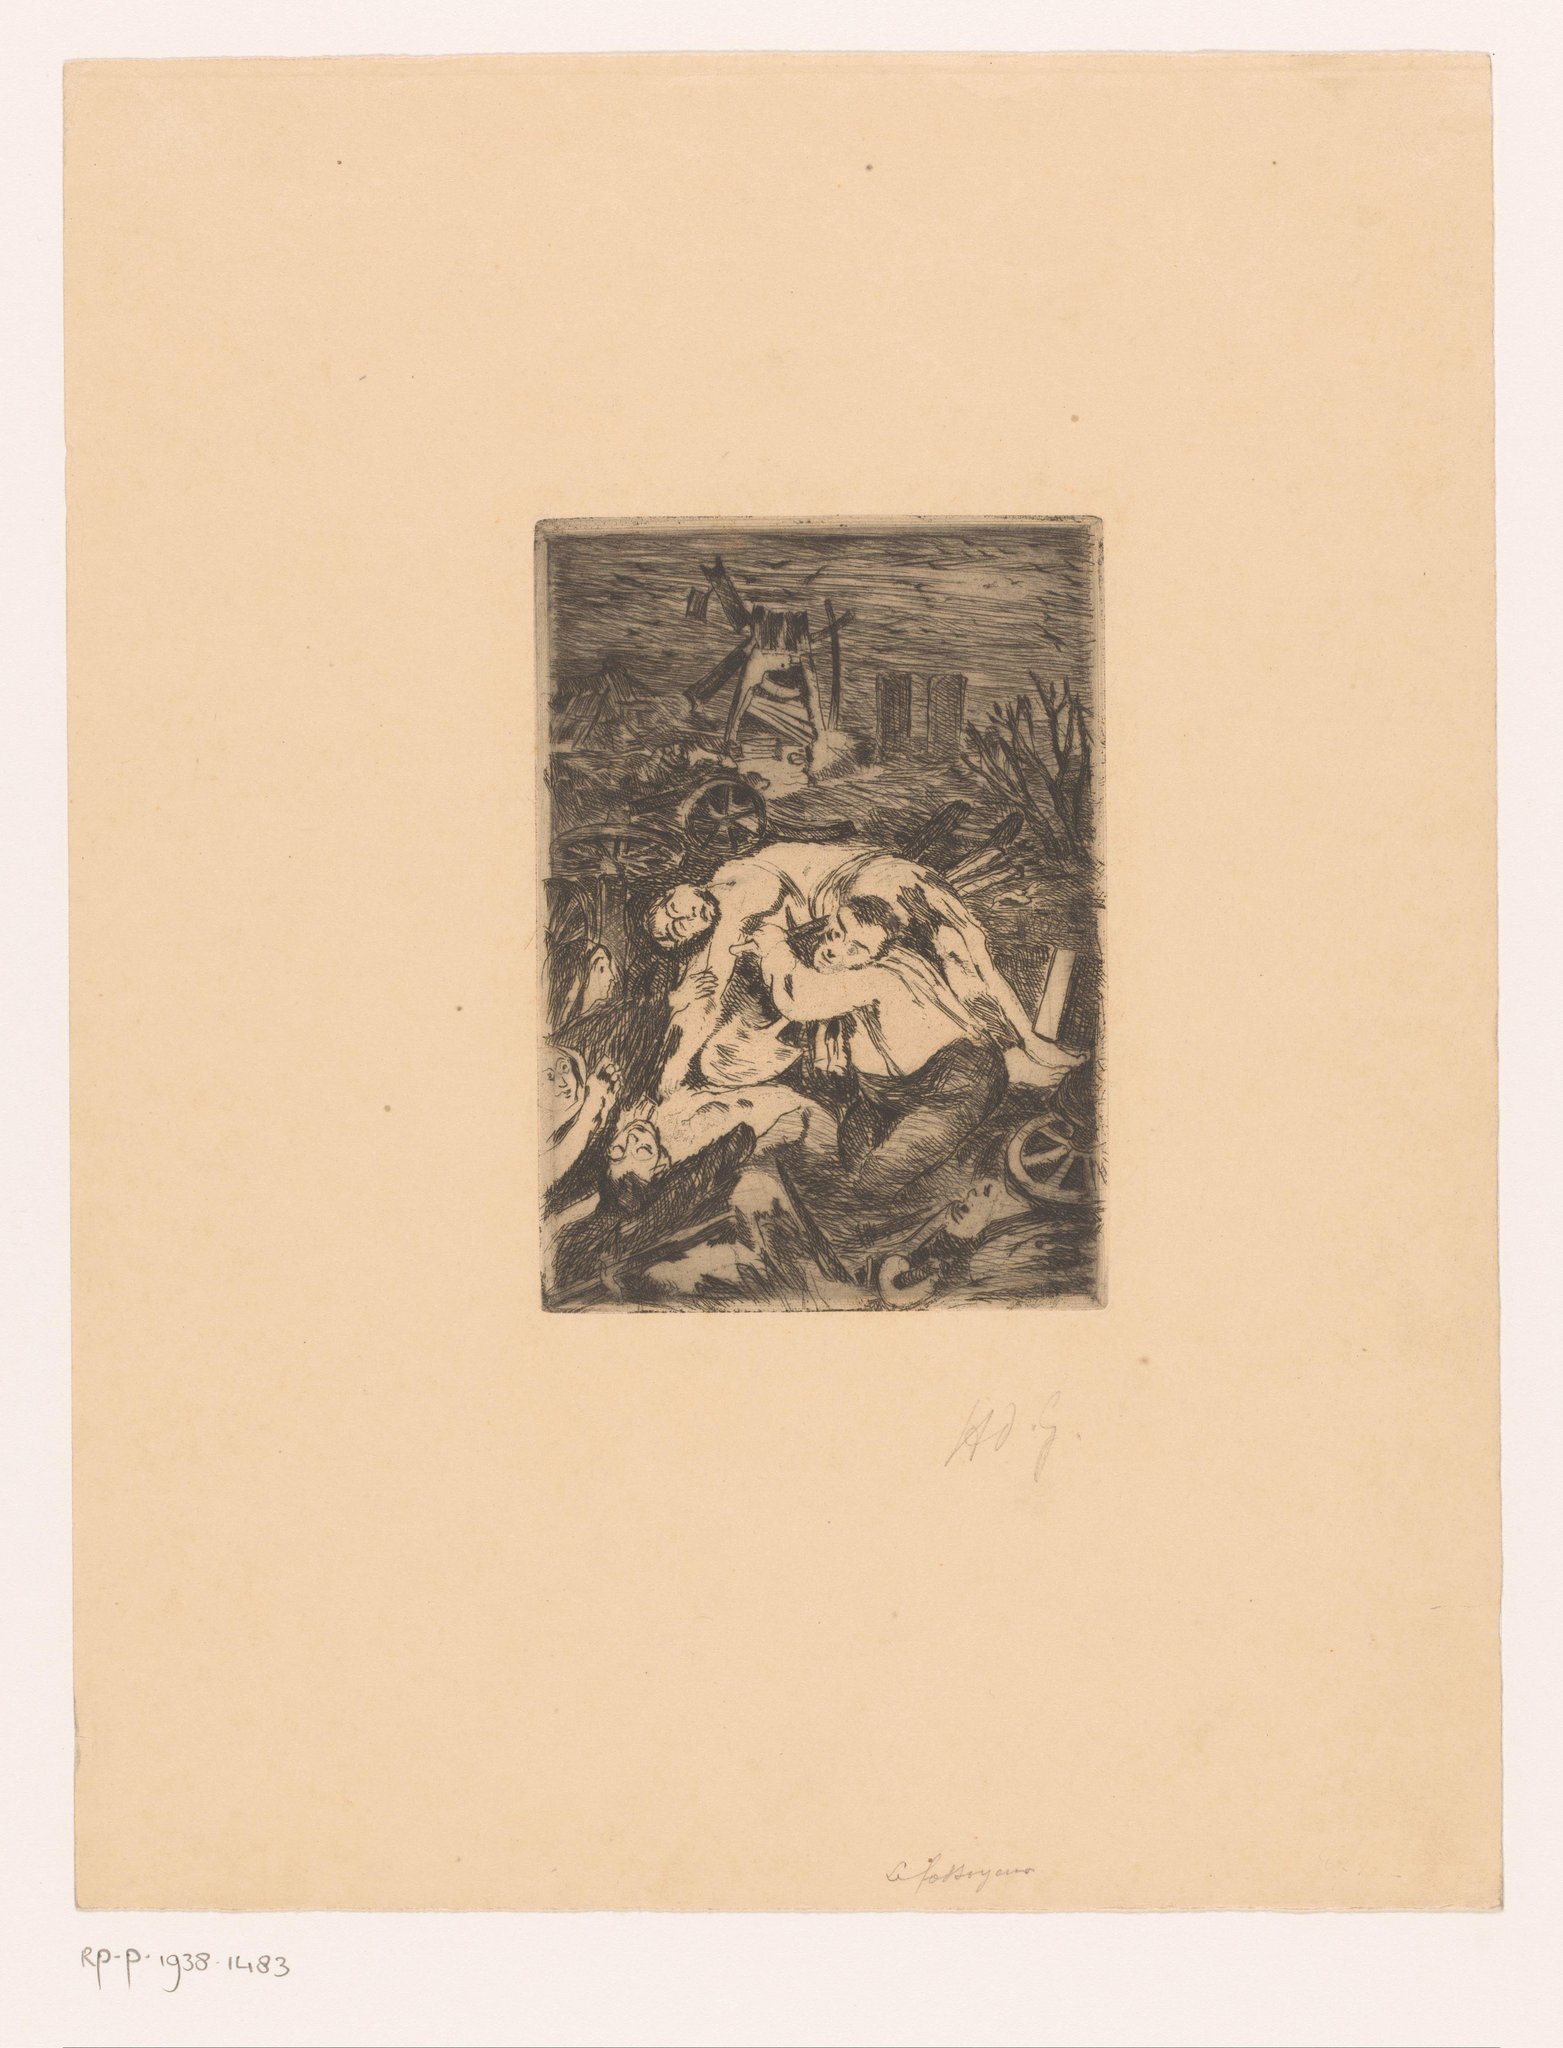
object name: print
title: Doodgraver op een slagveld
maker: henri de groux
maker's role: painter, print maker, sculptor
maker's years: 1866-1930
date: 1877-1930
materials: paper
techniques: etching, intaglio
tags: after the battle, grave digger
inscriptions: collector's mark: Lugt 2228, collector's mark: Lugt 2760